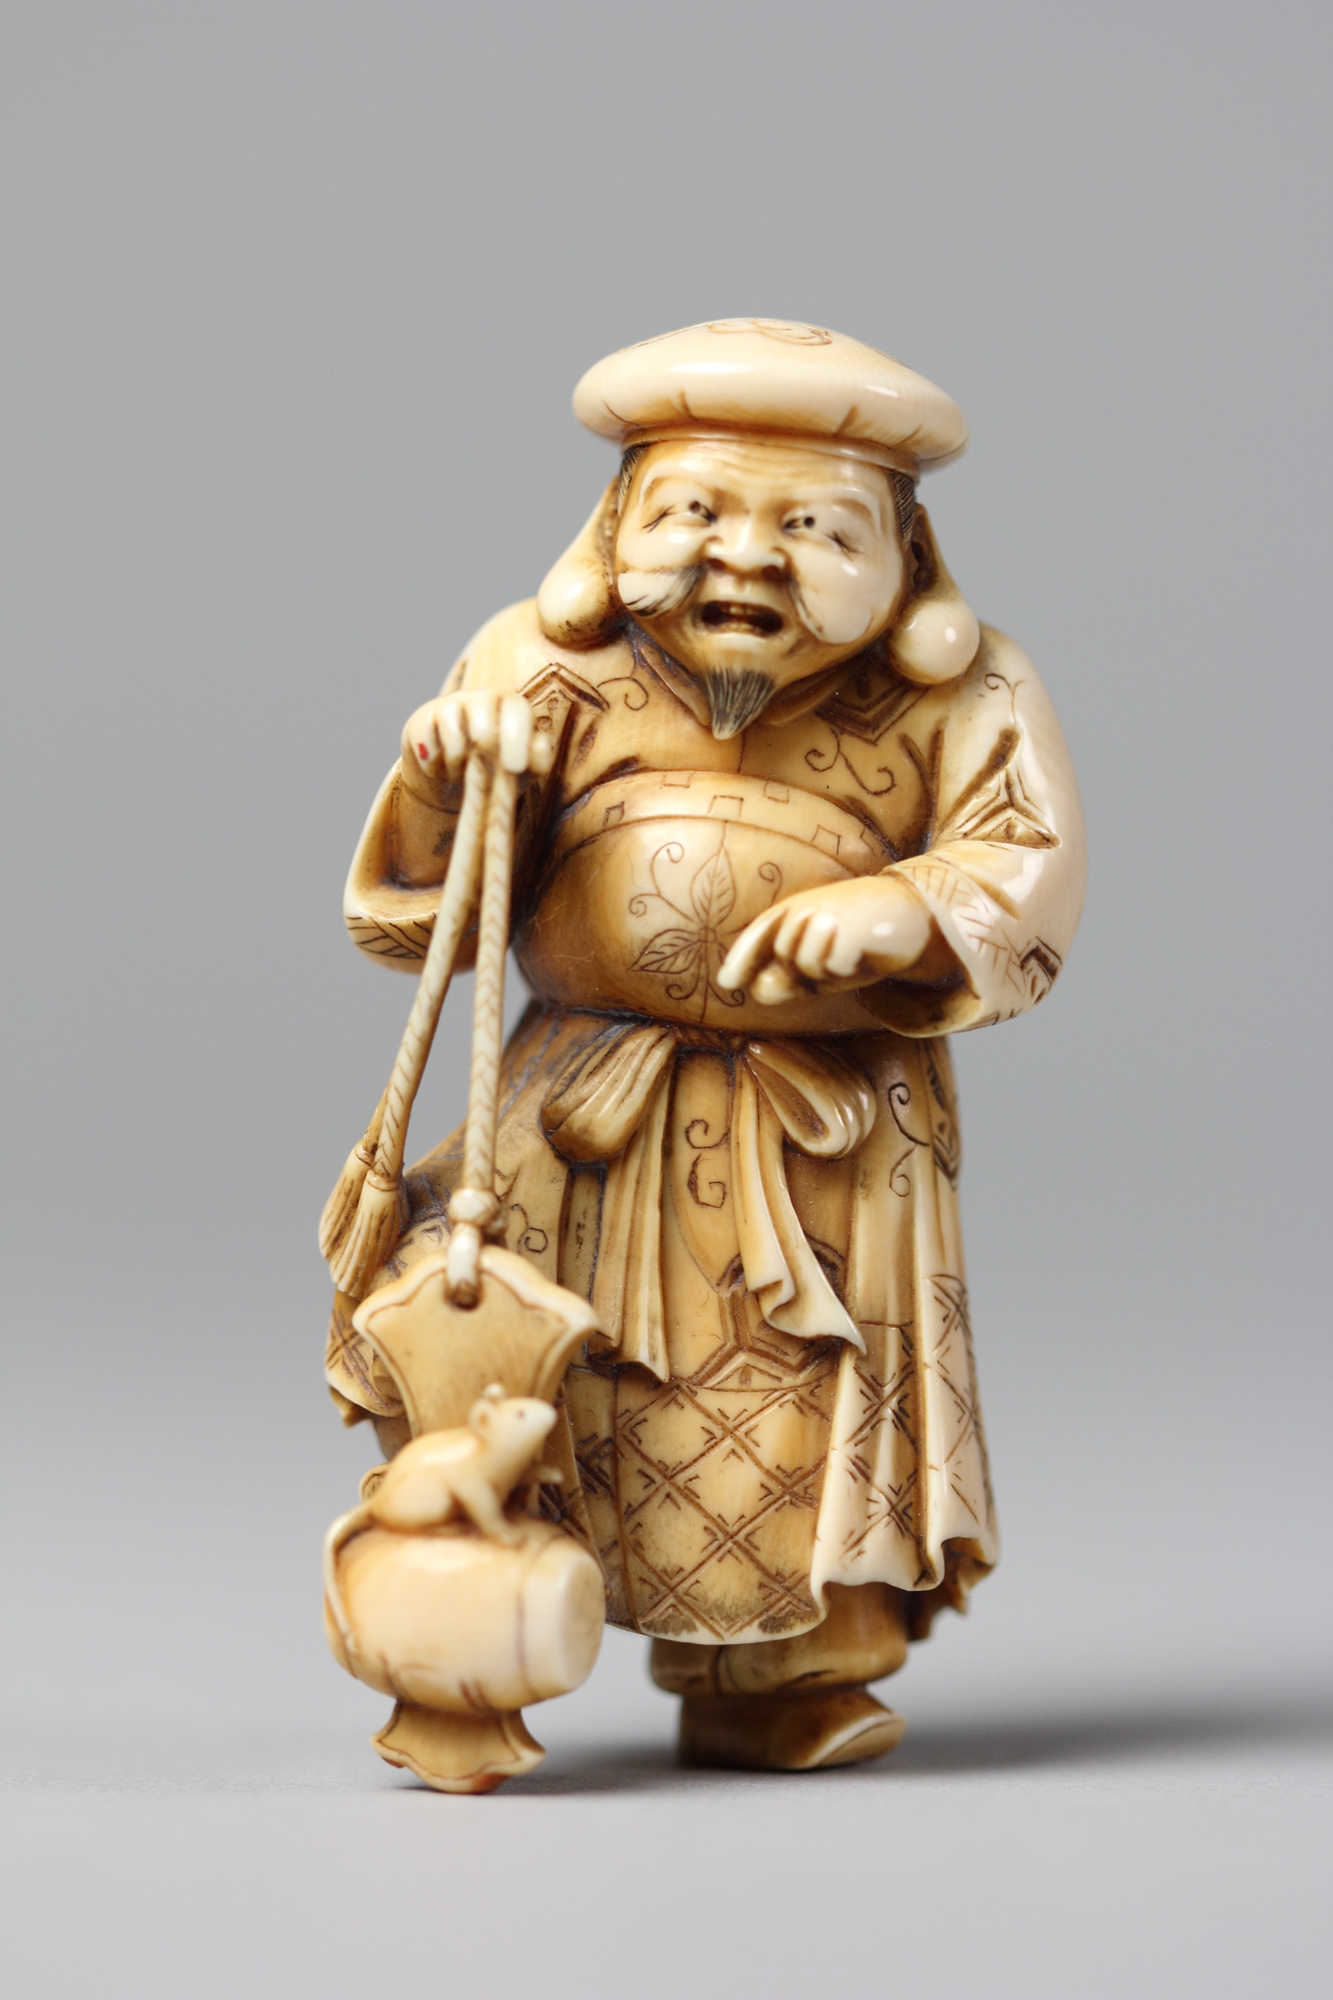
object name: netsuke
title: Netsuke of Figure of Daikoku with a Rat on His Mallet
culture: japanese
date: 1801-1900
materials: ivory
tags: animals,men